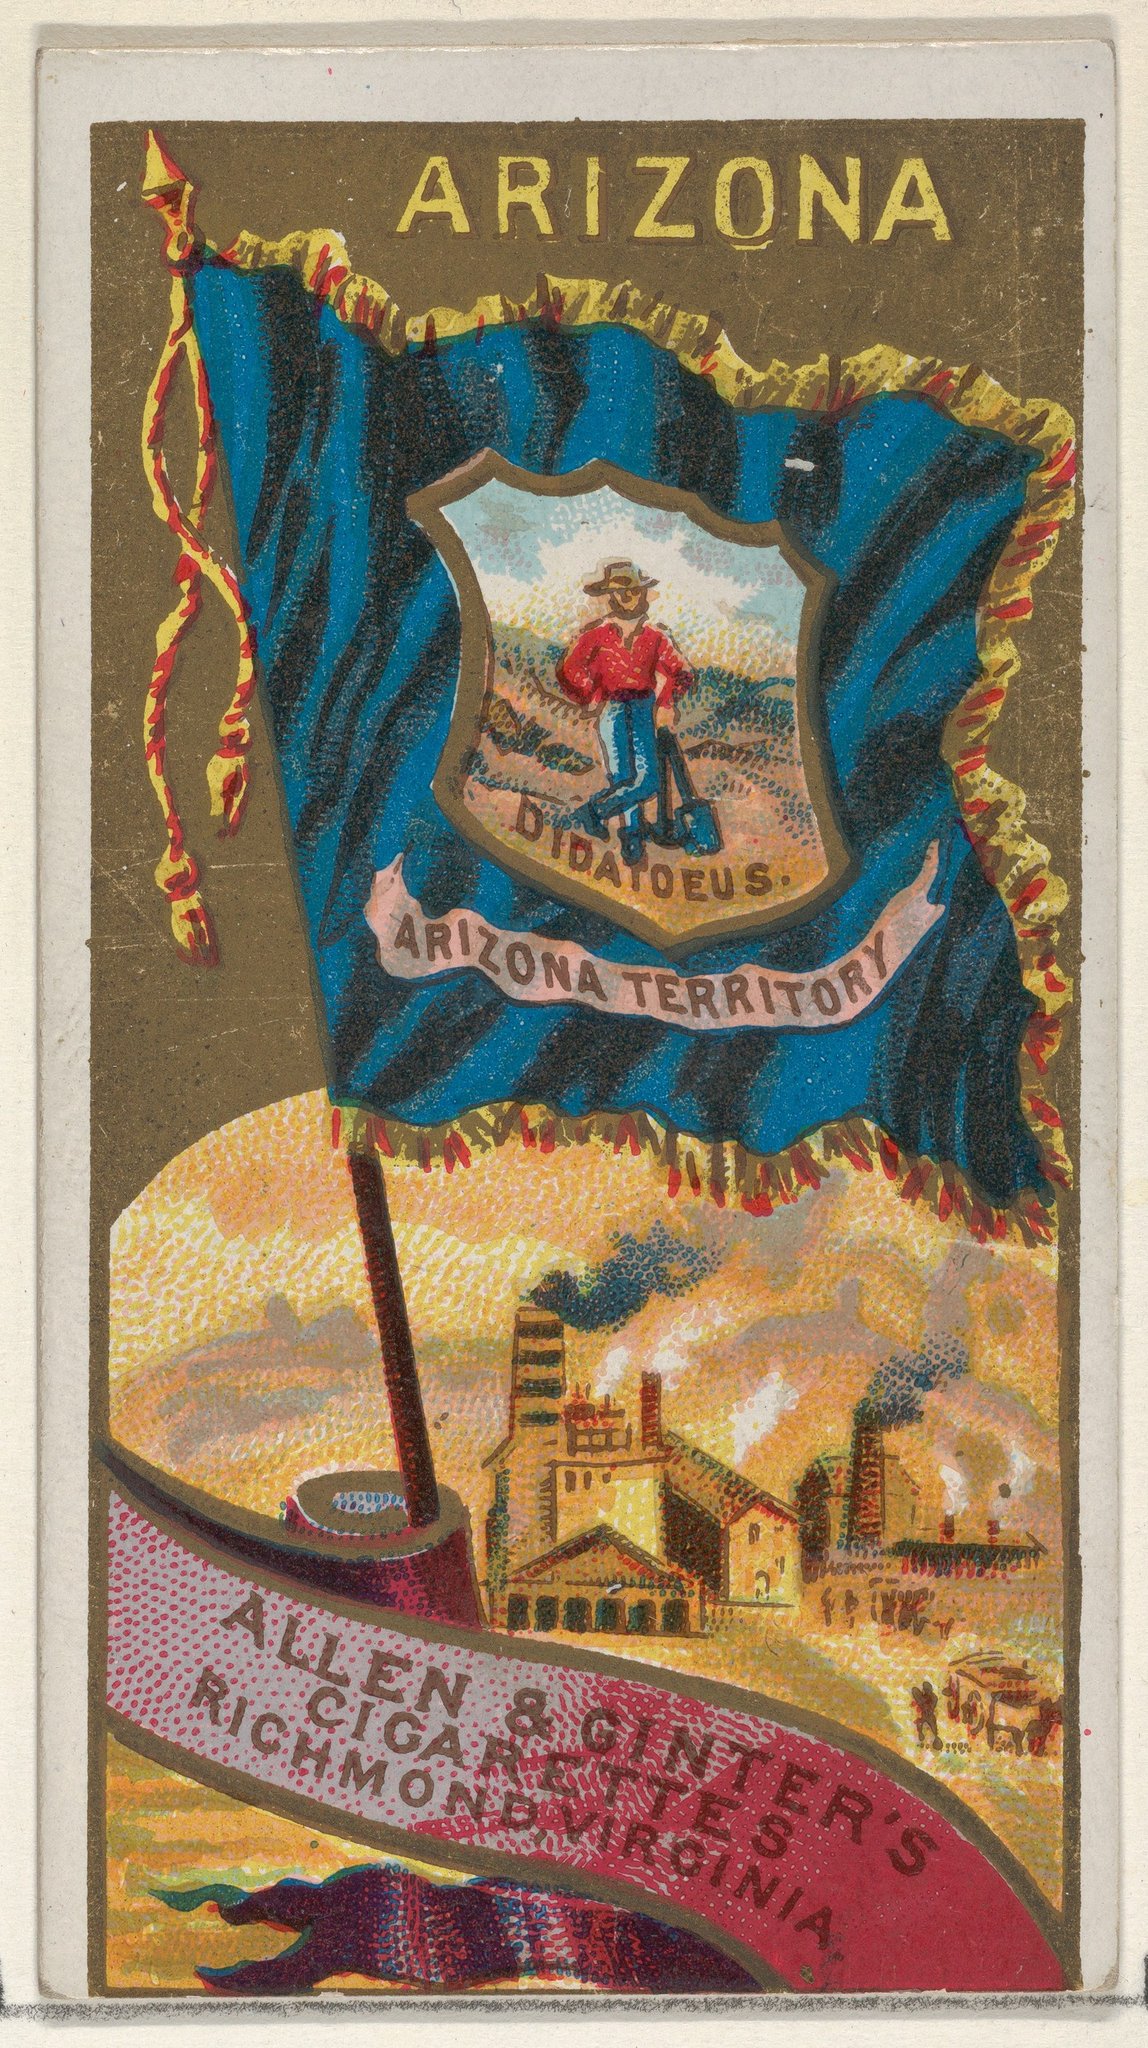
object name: print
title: Arizona, from Flags of the States and Territories (N11) for Allen & Ginter Cigarettes Brands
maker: allen & ginter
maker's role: publisher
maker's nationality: american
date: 1888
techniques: color lithograph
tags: flags